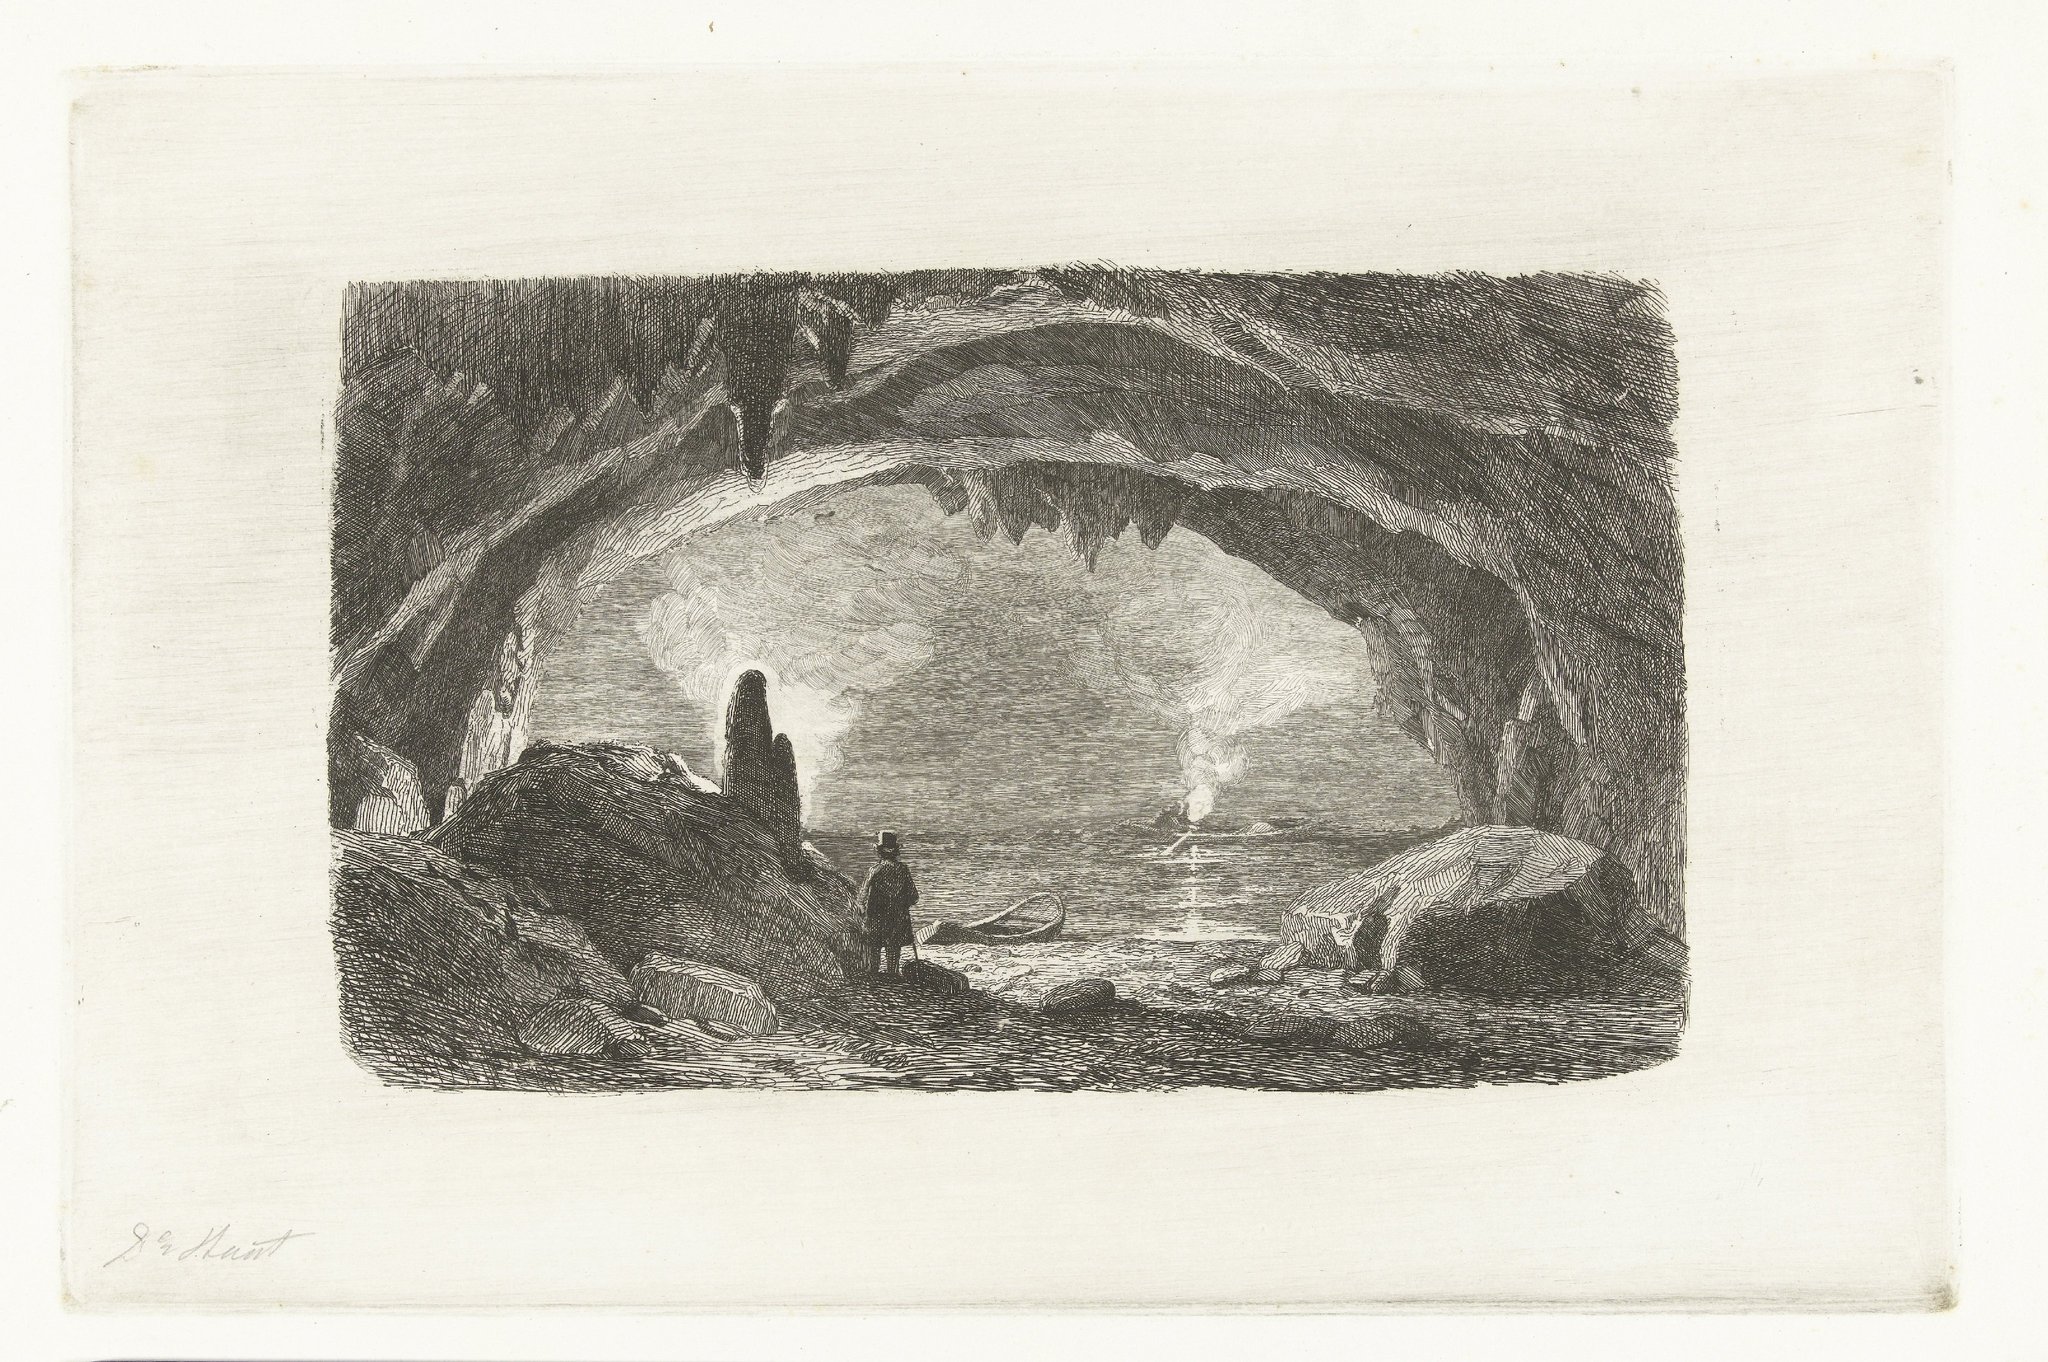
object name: print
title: Man met roeiboot in de grotten van Han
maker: pierre louis dubourcq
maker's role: draughtsman, painter, print maker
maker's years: 1815-1873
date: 1849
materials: paper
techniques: steel etching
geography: netherlands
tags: cave, grotto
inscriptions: collector's mark: Lugt 2228